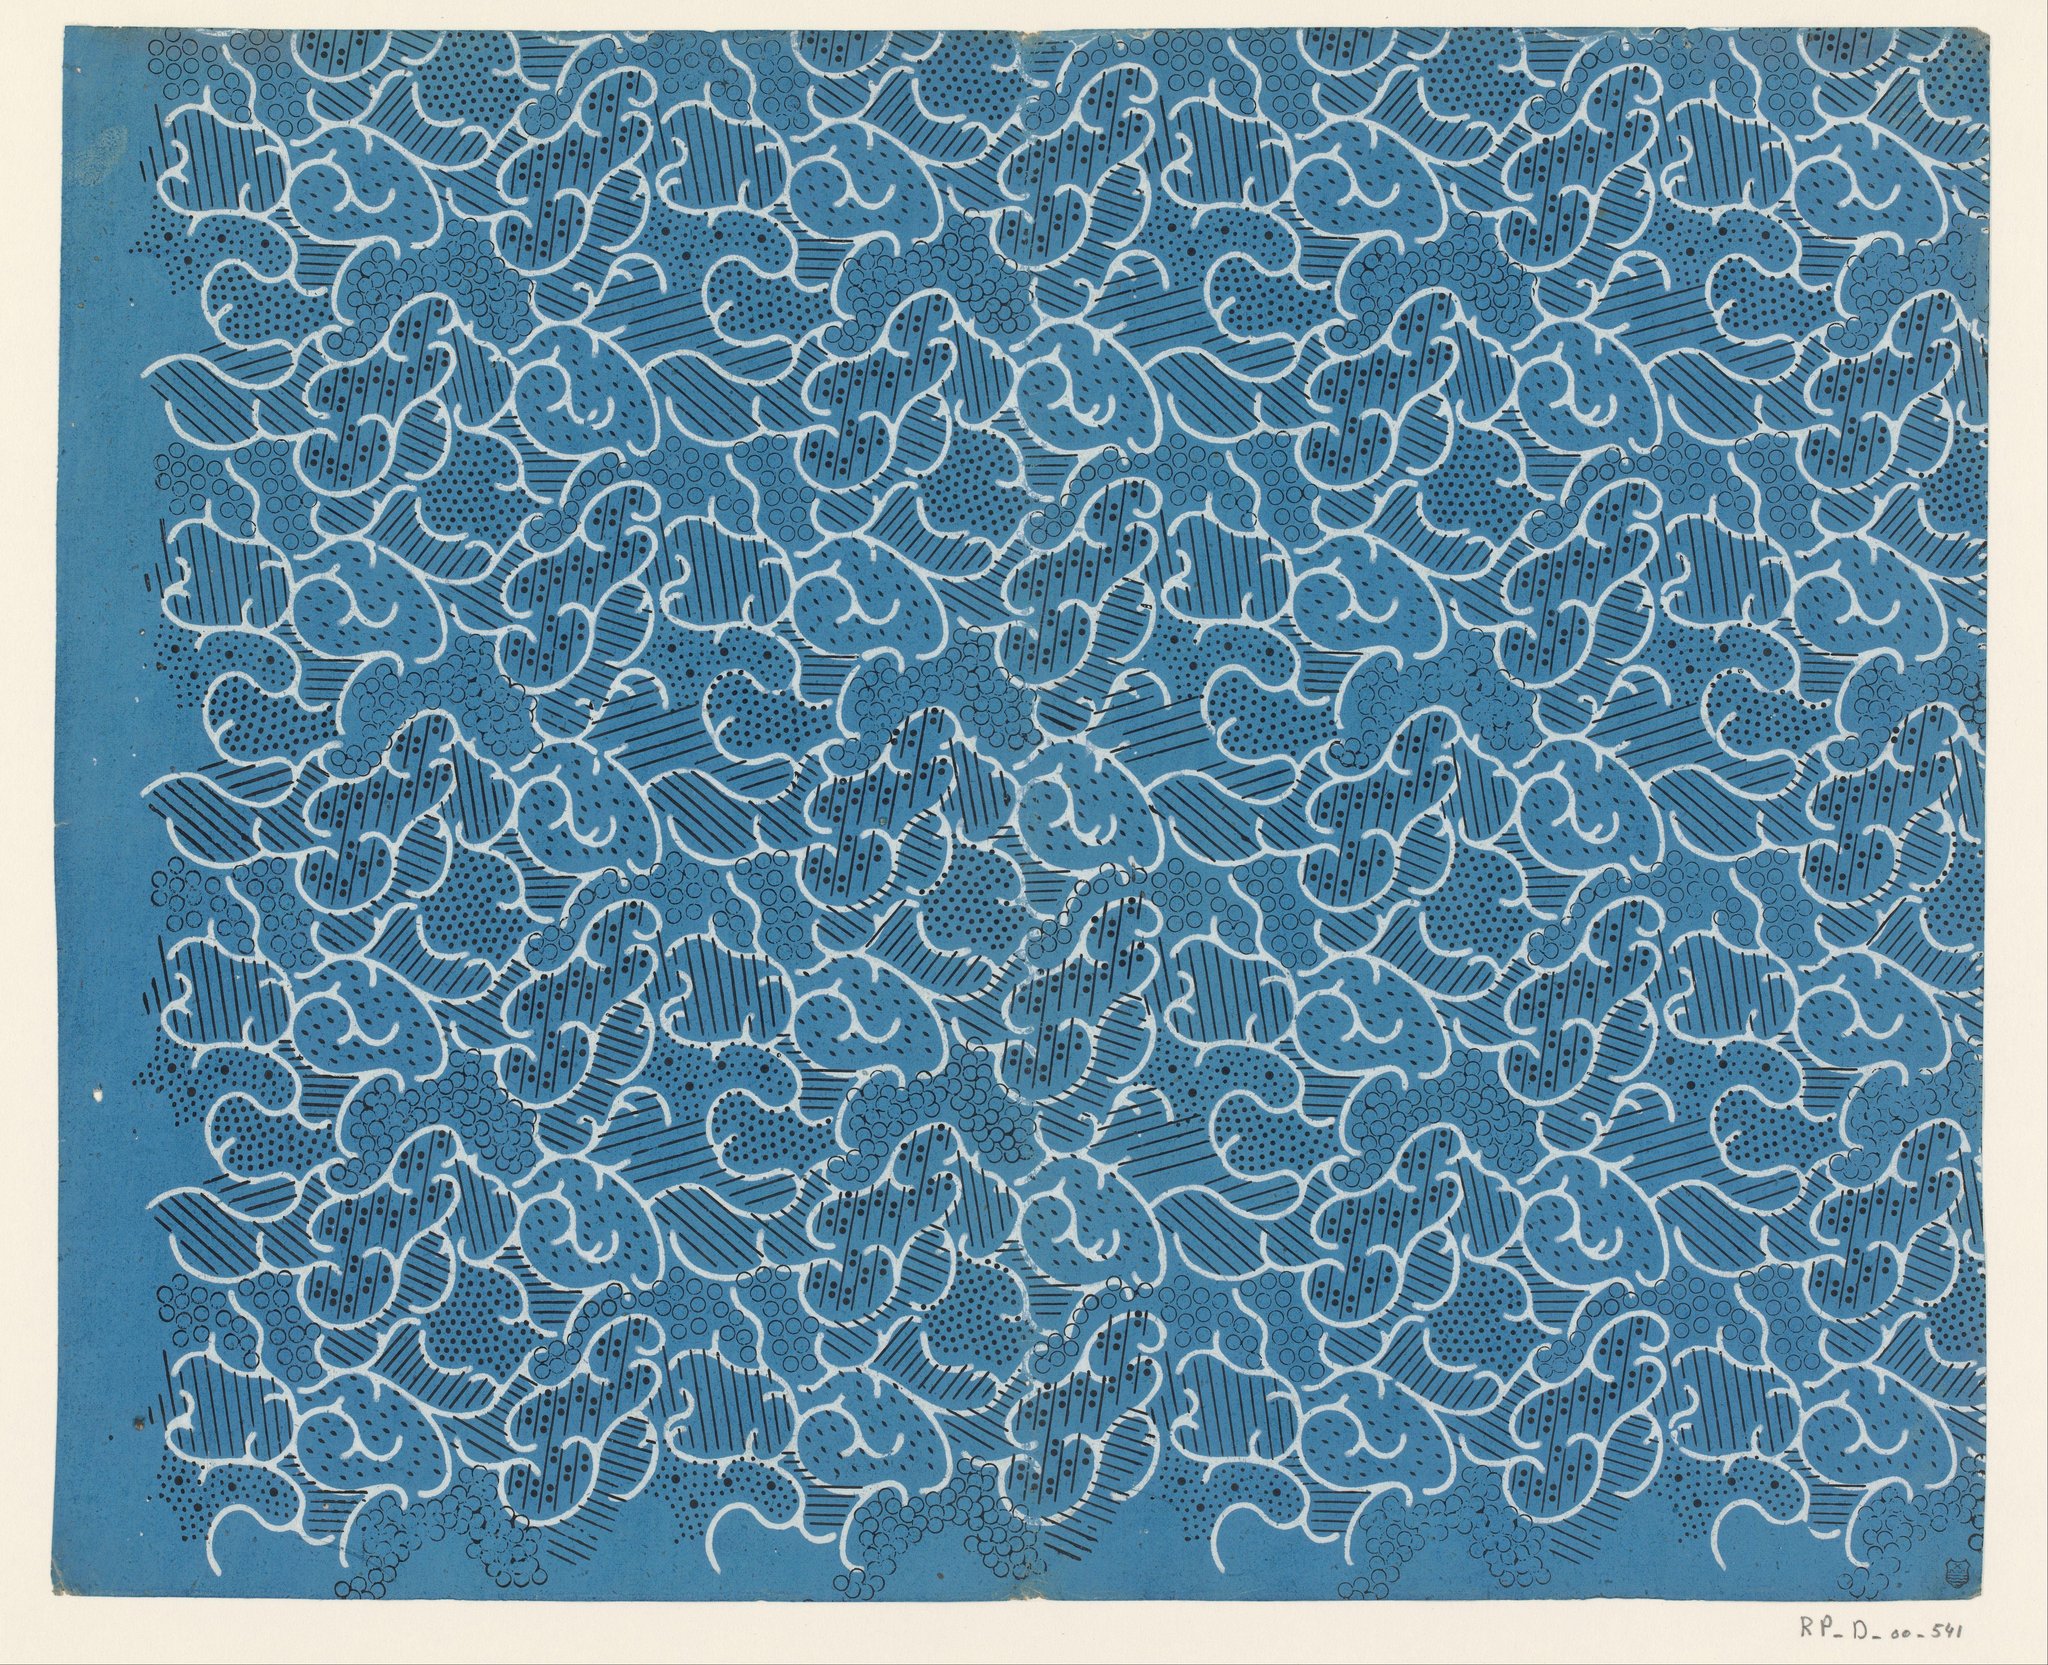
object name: printed paper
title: Blad met strooipatroon van ranken en diverse motieven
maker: Anonymous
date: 1800-1900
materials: paint, paper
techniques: printing block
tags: ornament ~ geometric motifs, ornament derived from plant forms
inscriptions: collector's mark: Lugt 2760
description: Blad met strooipatroon van gestileerde ranken en diverse motieven met stippen, trossen en lijnen.